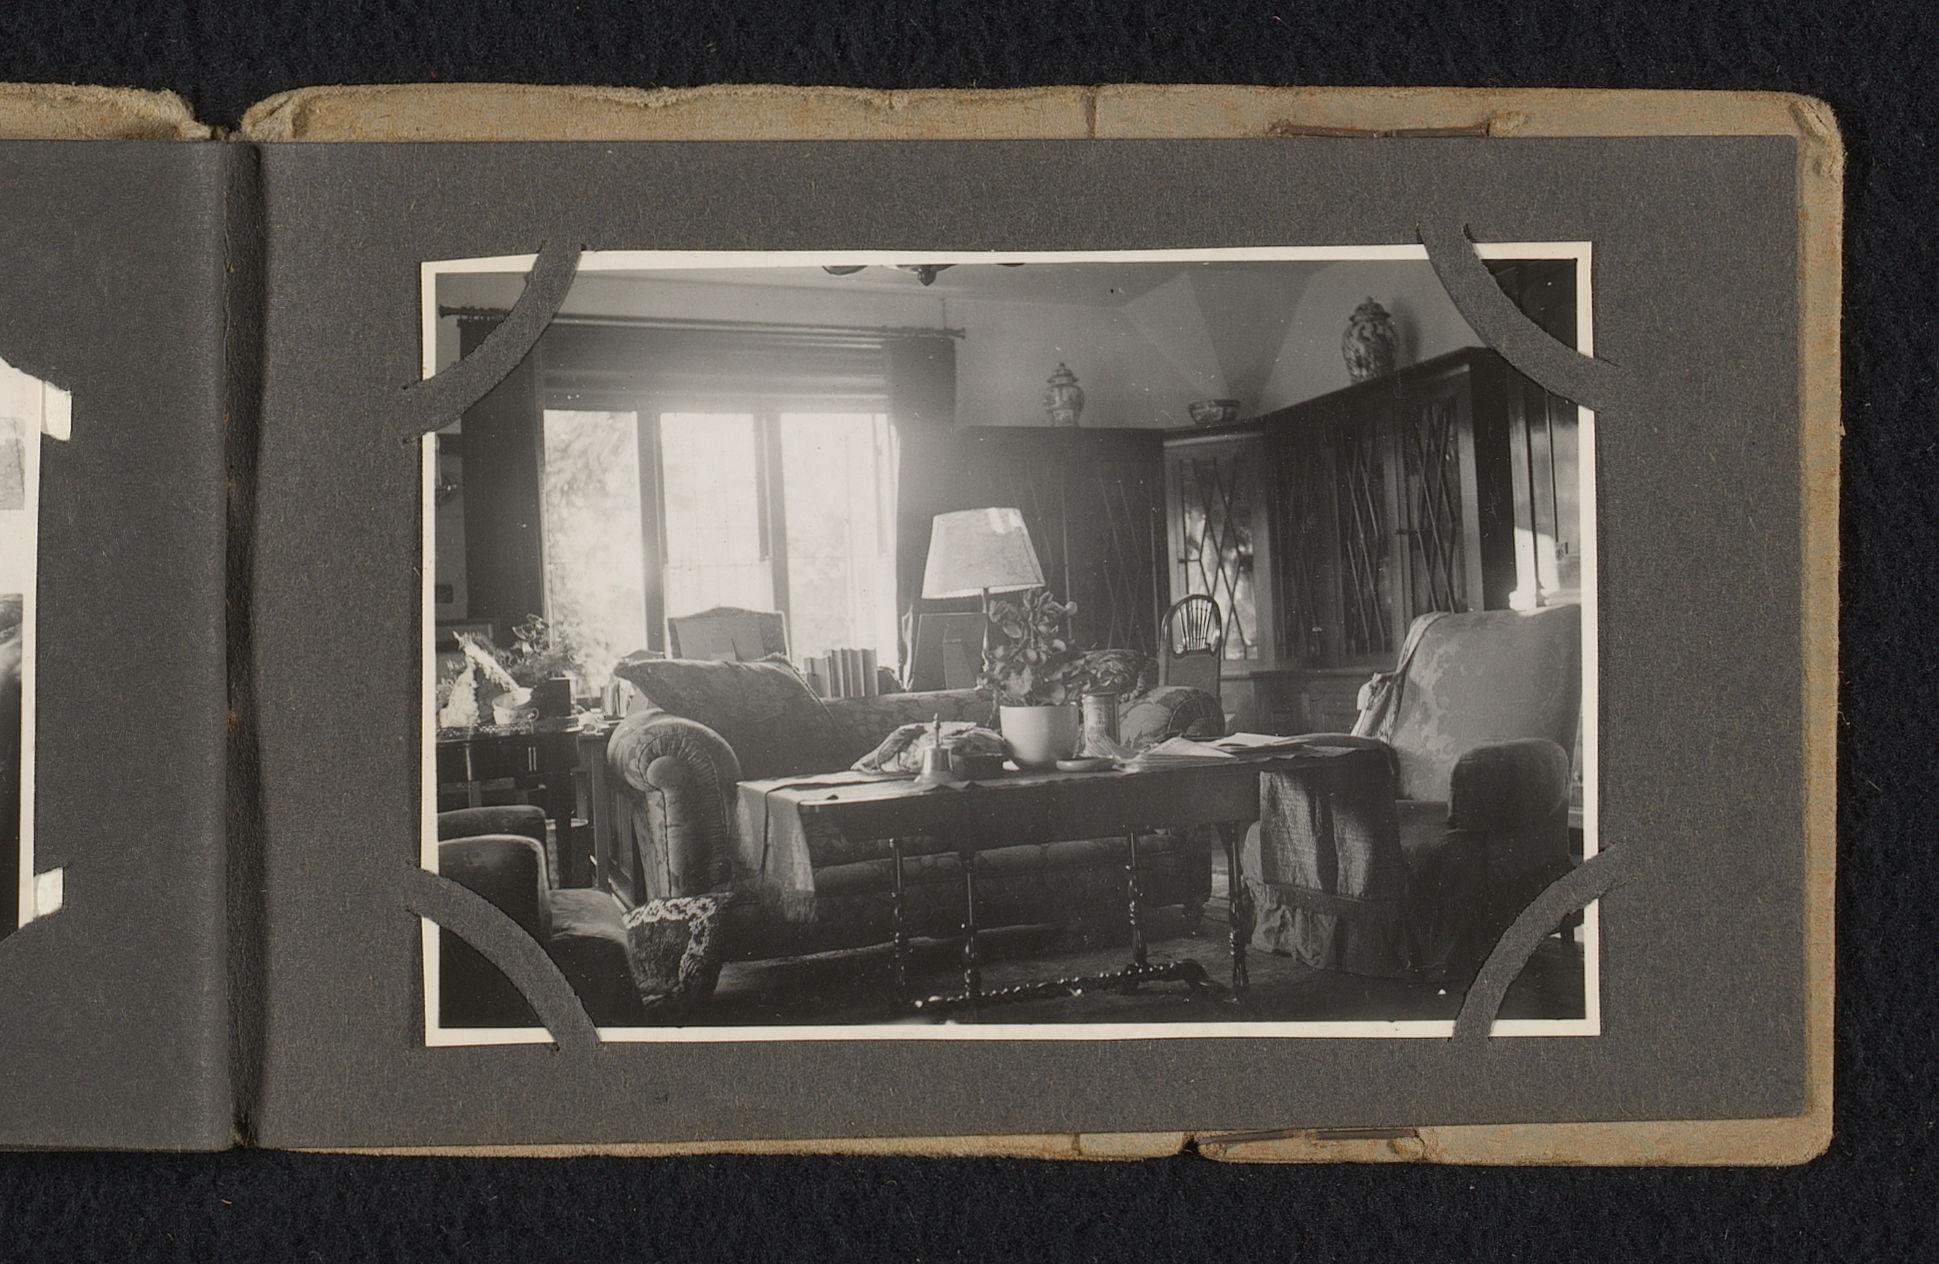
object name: photograph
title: Zitkamer in het landhuis De Wilde Zwanen te Laren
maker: norbert van den berg (1901-1972)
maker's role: amateurfotograaf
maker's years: 1901-1972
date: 1940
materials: paper, cardboard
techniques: gelatin silver print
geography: laren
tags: interior of the house, living-room, parlour, sitting-room